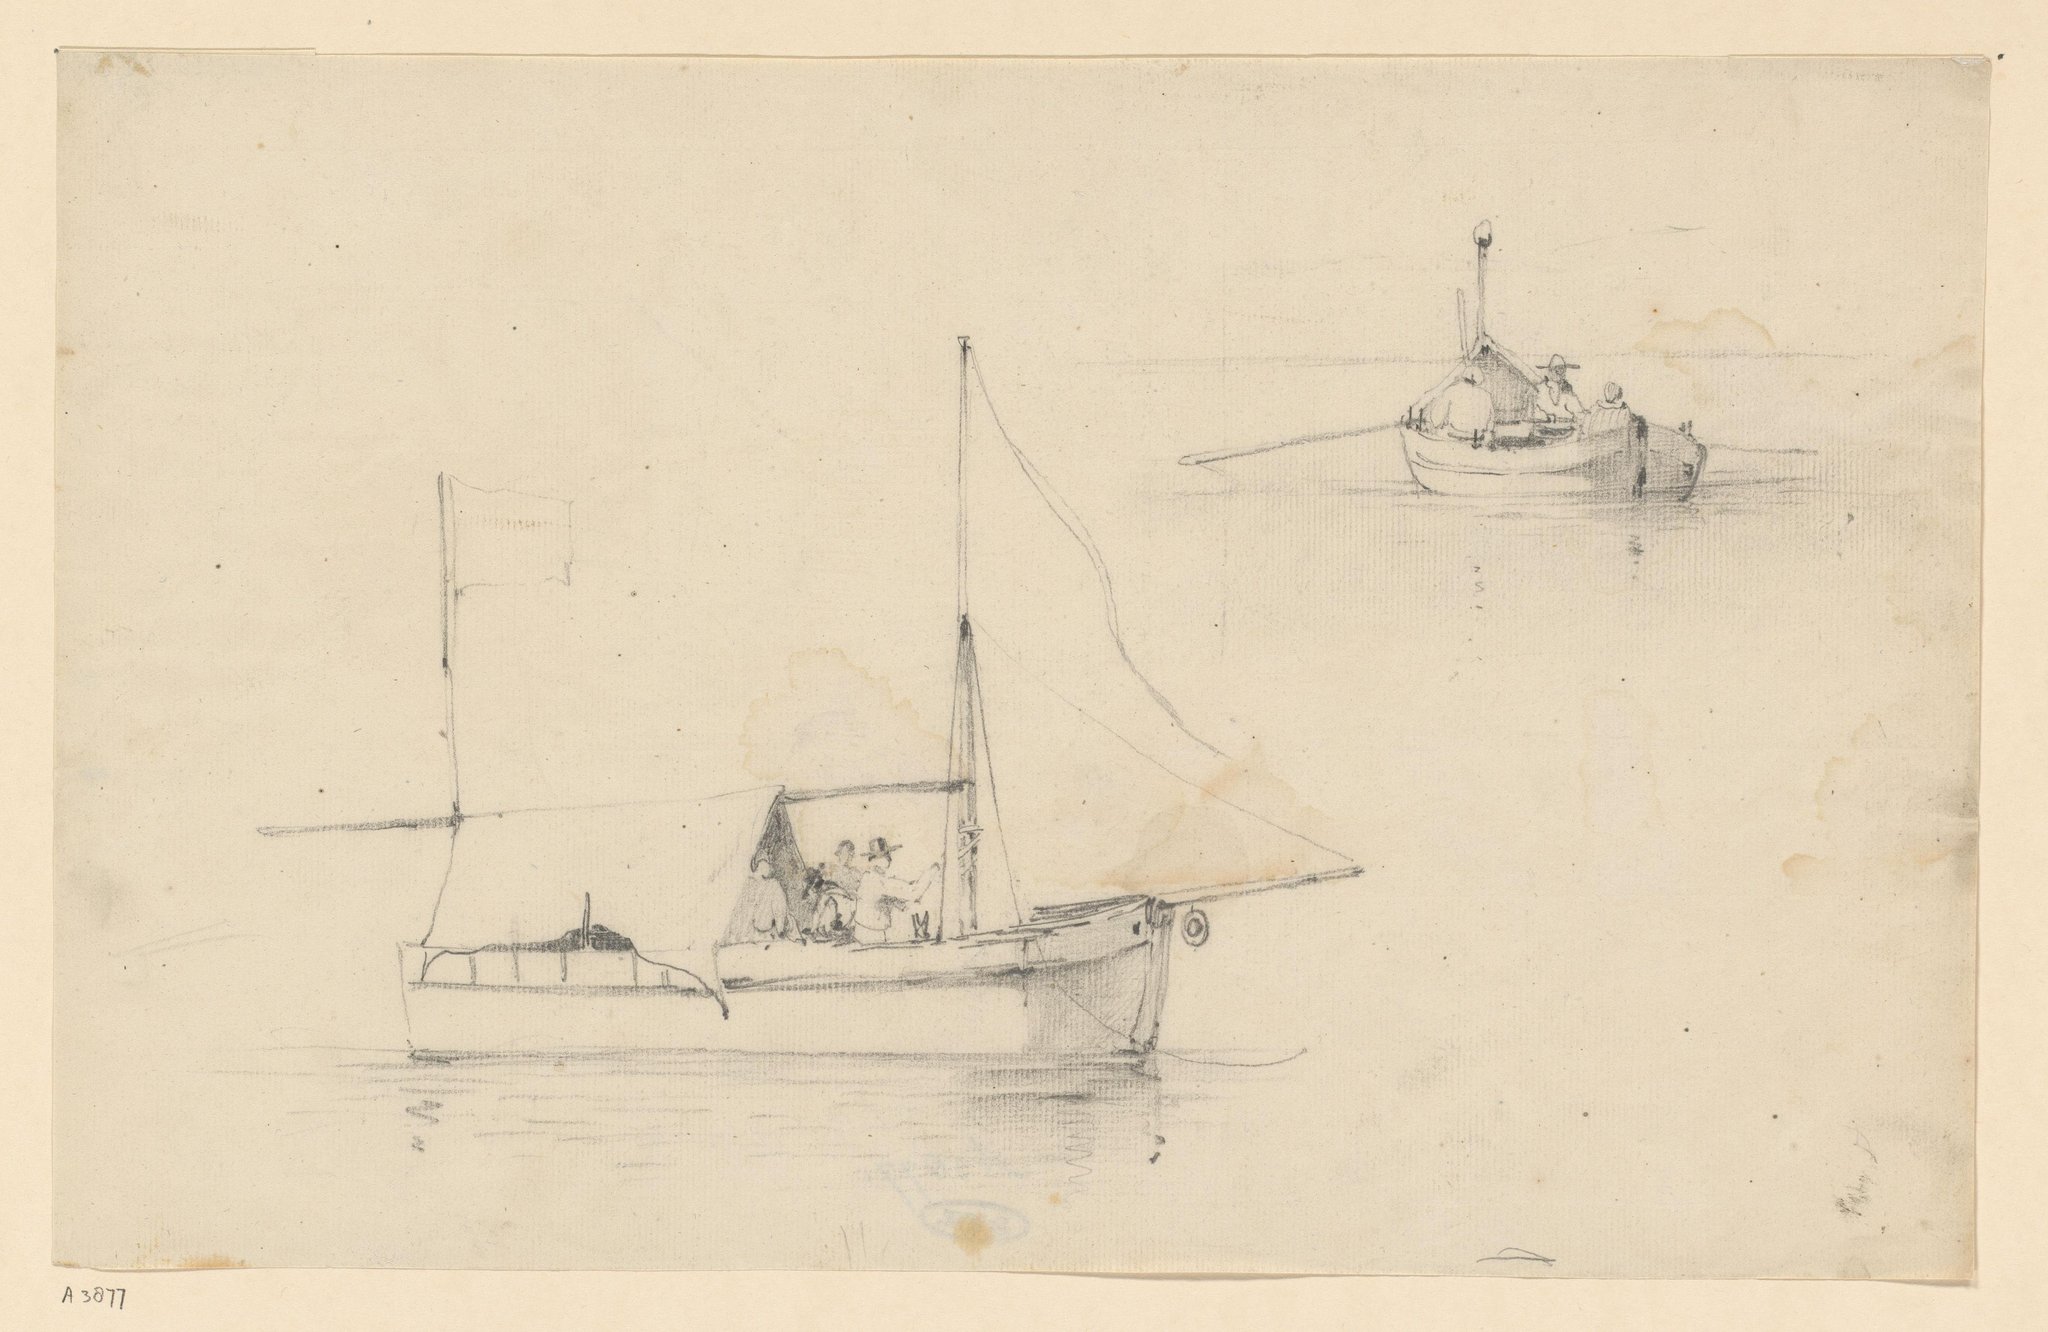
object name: drawing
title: Een roeiboot en een grotere boot met overkapping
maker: willem anthonie van deventer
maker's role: draughtsman, painter, print maker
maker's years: 1824-1893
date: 1834-1893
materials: paper, pencil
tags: sailing-ship, sailing-boat, rowing-boat, canoe, etc.